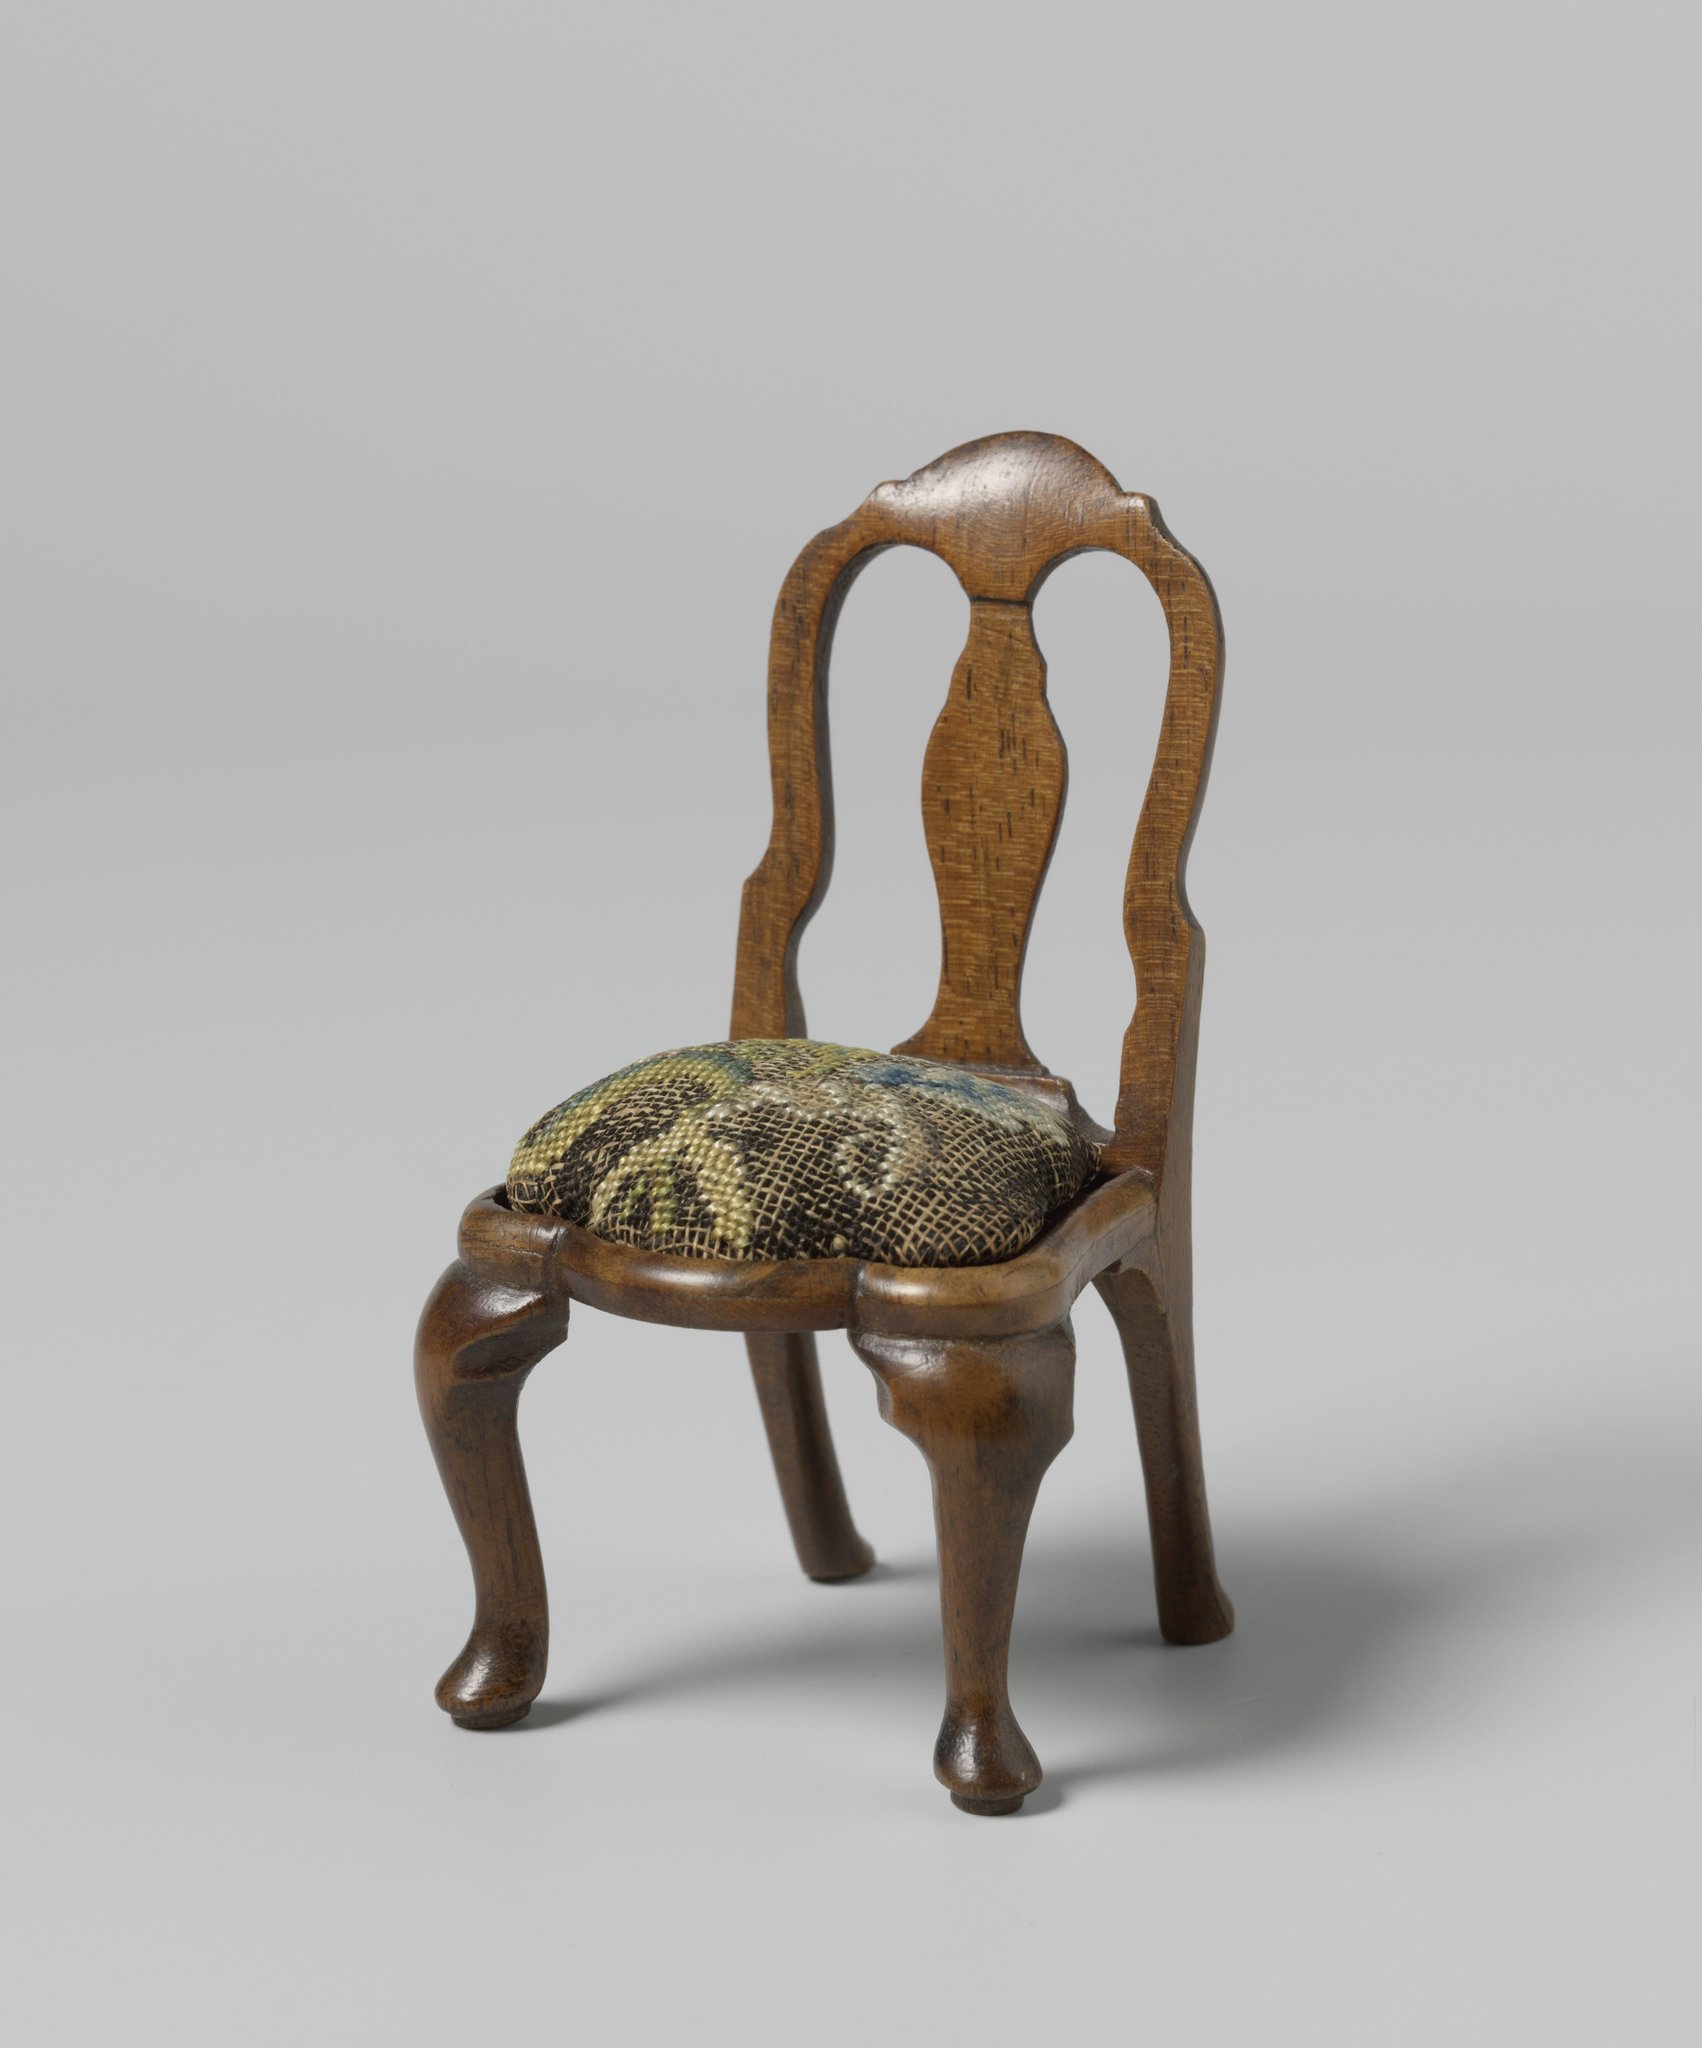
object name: chair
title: Stoel, behorend tot een elfdelig ameublement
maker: Anonymous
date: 1750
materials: silk, wood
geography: amsterdam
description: Stoel, vervaardigd van notenhout, behorend tot een elfdelig ameublement, bestaande uit een bank en tien stoelen. De zitting van buurduurwerk met blad- en bloemmotieven in zijde op linnen stramien, met een zachte vulling.